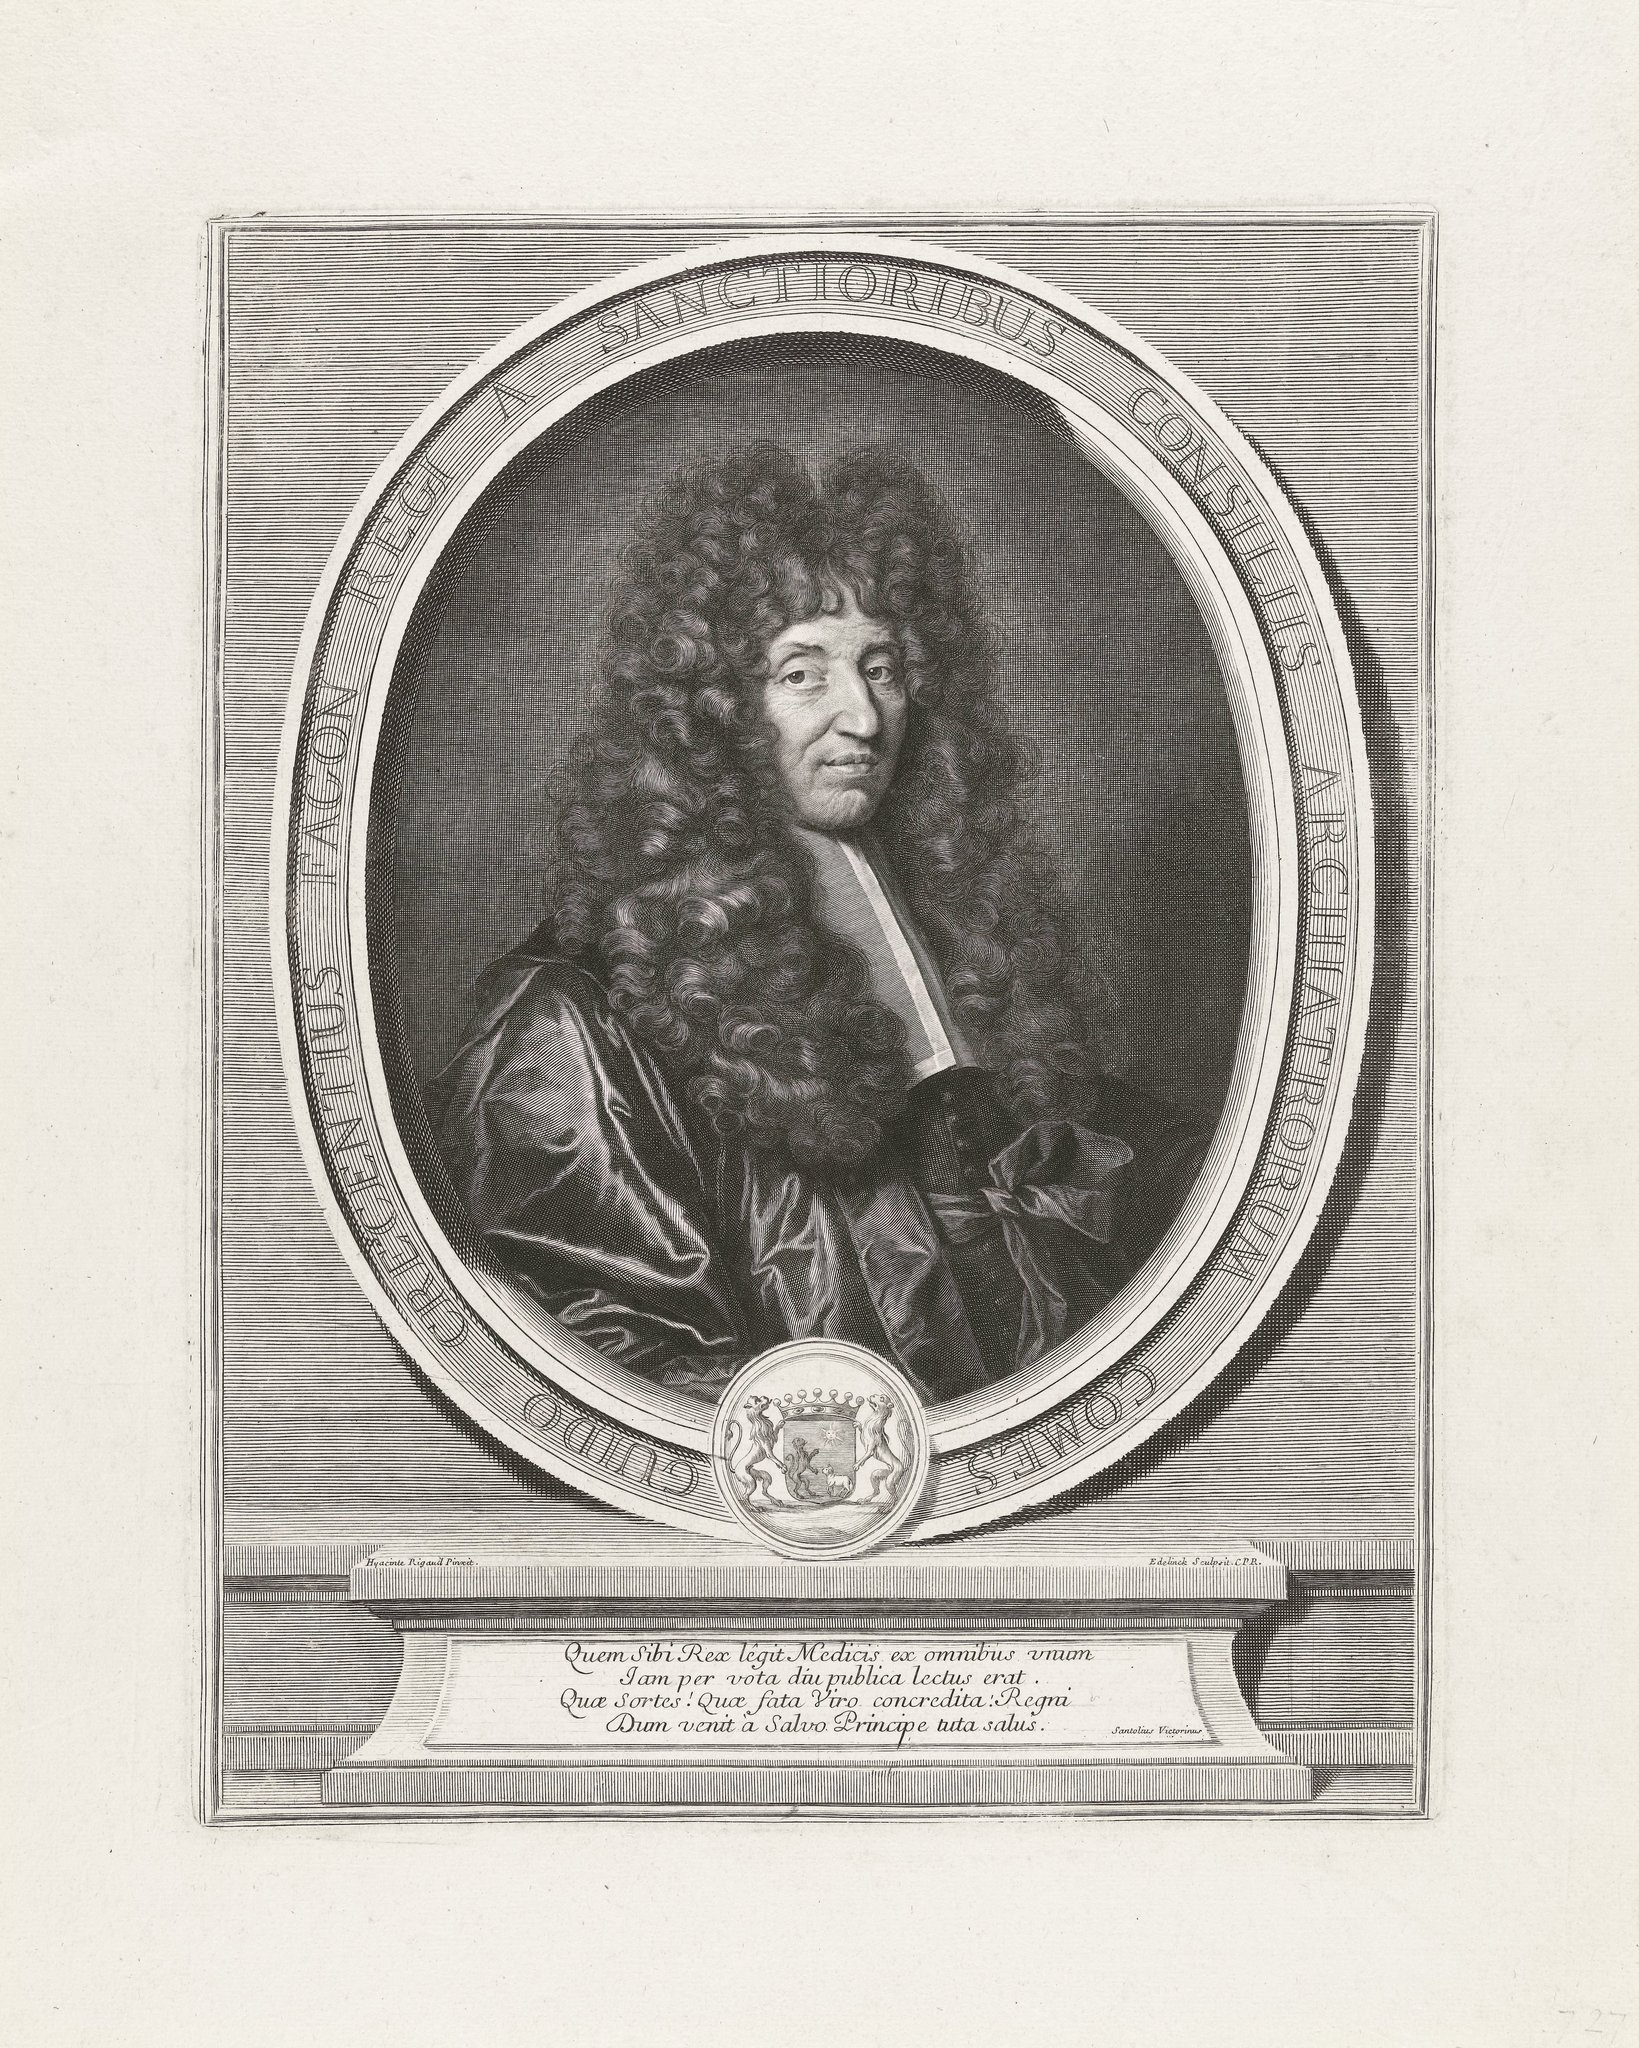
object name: print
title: Portret van Guy-Crescent Fagon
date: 1666-1707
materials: paper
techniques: engraving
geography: france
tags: botanicus, guy-crescent fagon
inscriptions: collector's mark: Lugt 240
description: Portret van Guy-Crescent Fagon (1638-1718), lijfarts van koning Lodewijk XIV, afgebeeld in ovale omlijsting met tekst en wapen. Op console met vier regels Latijnse tekst.